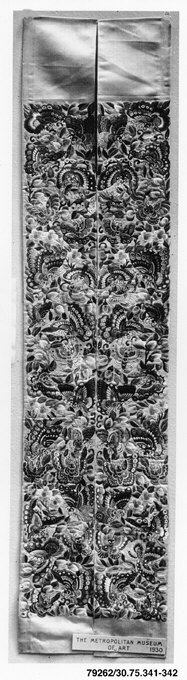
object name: sleeve band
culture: chinese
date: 1801-1900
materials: silk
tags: butterflies